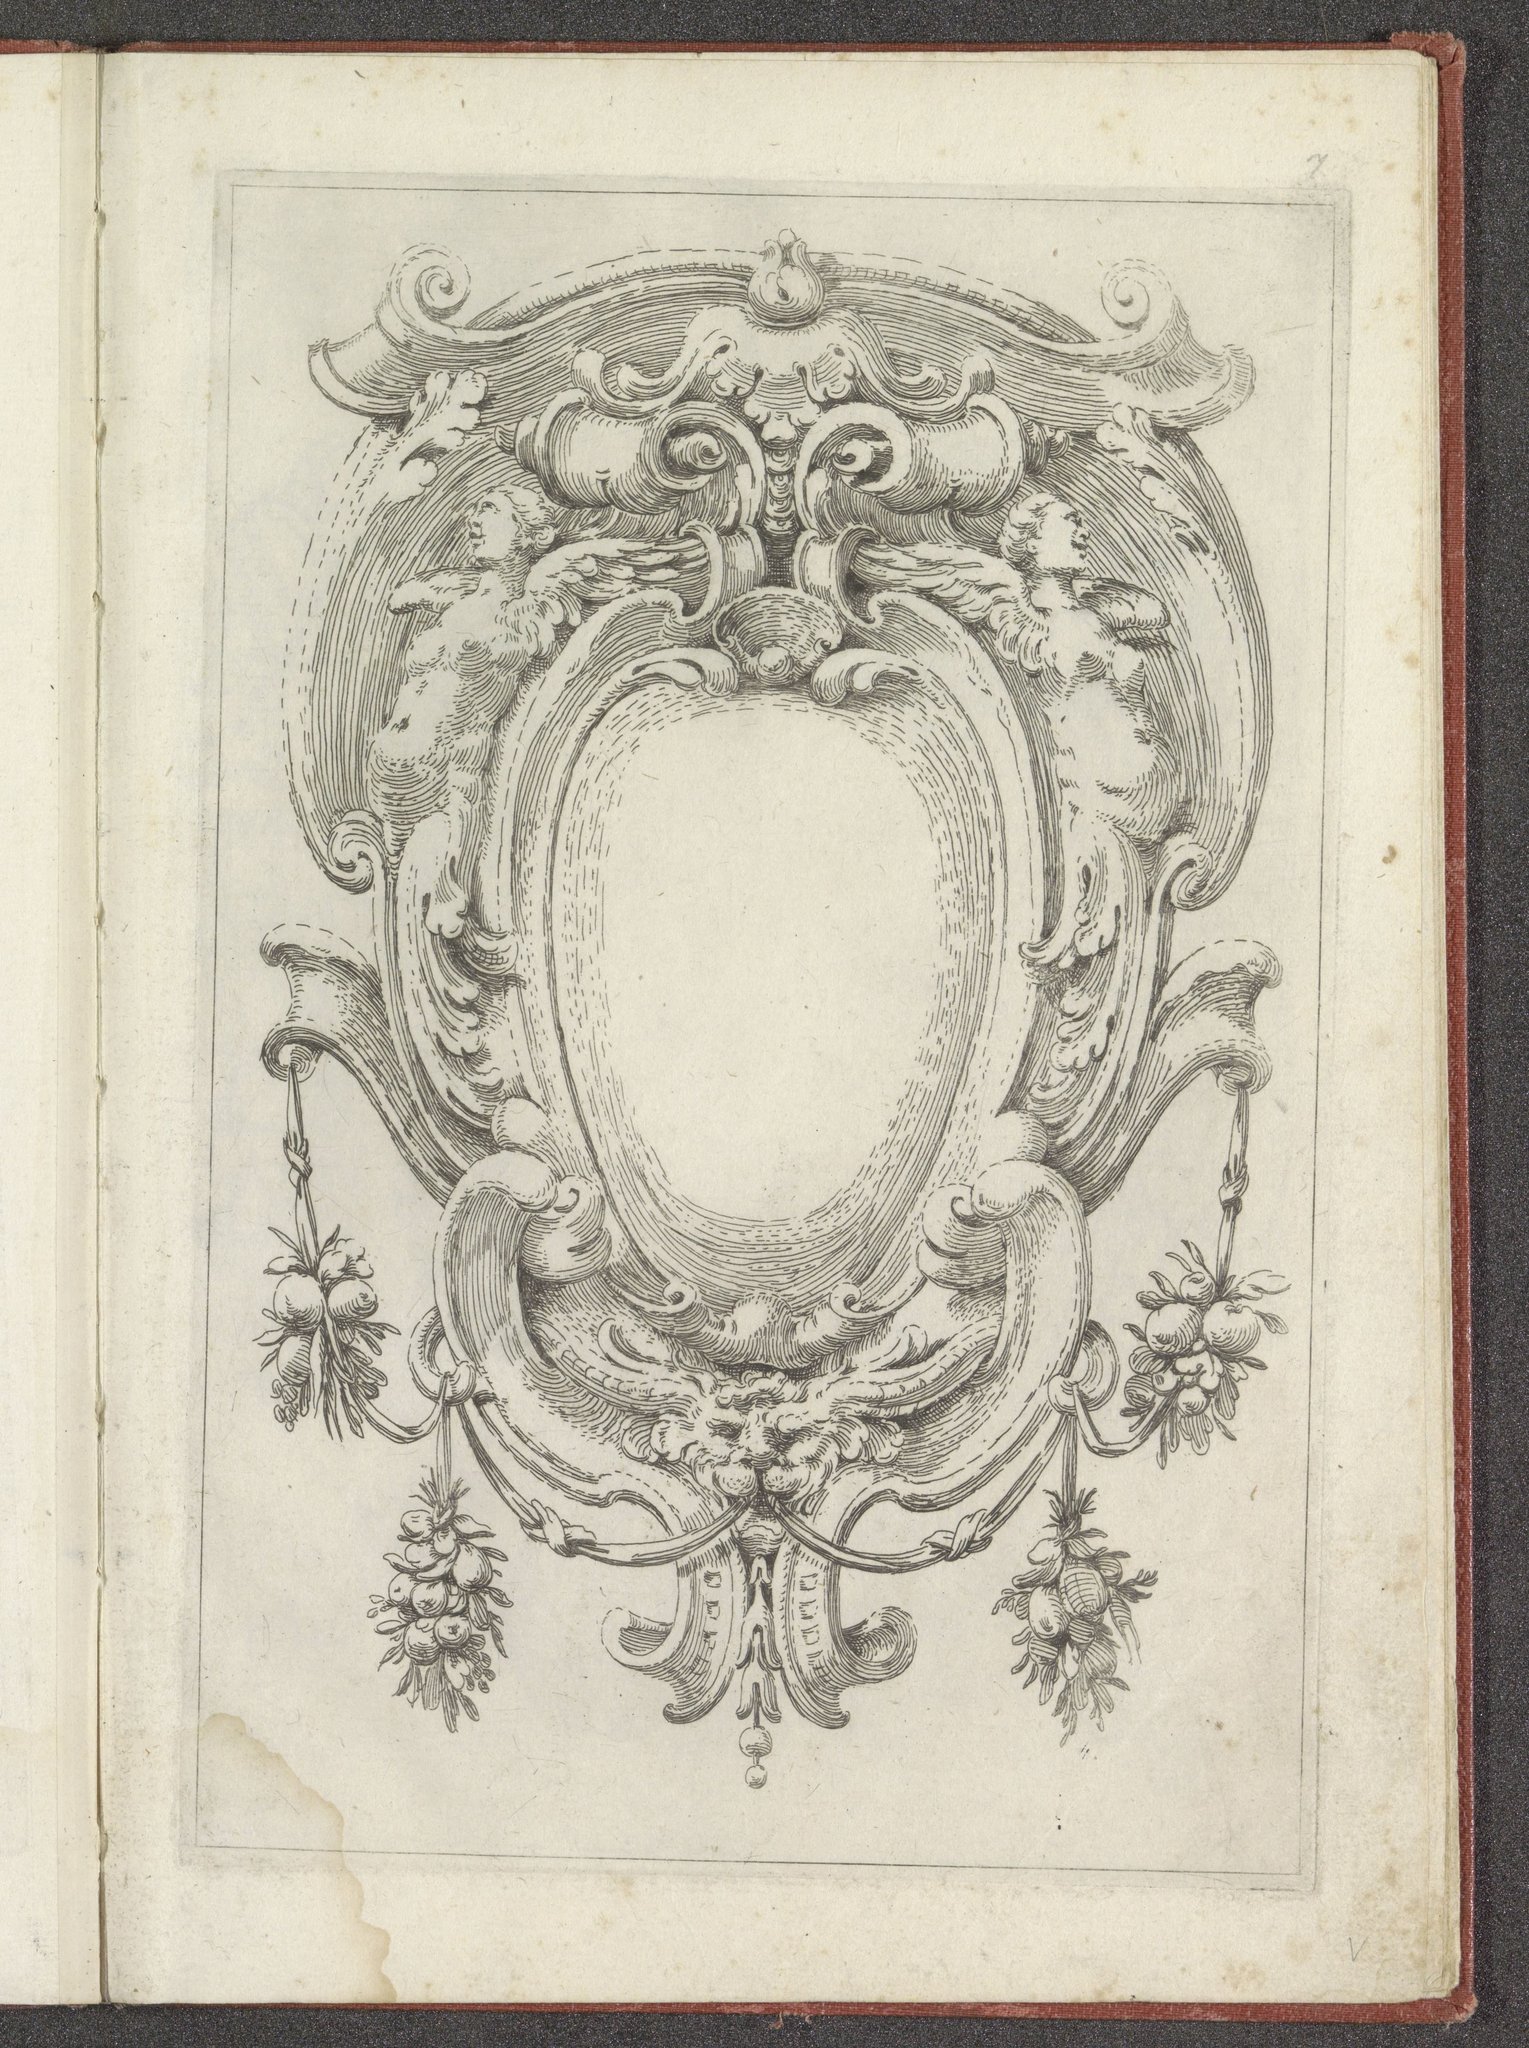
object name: album leaf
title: Cartouches par Mitelli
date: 1636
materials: paper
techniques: etching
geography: rome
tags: fabulous beings with wings - aa - female human figure, ornament ~ cartouche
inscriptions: collector's mark: Lugt 2228, collector's mark: Lugt 2760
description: Een cartouche met in de rand gevleugelde vrouwenfiguren die overlopen in ornament. Onder aan het cartouche hangen vier trossen met vruchten. De prent maakt deel uit van een album.